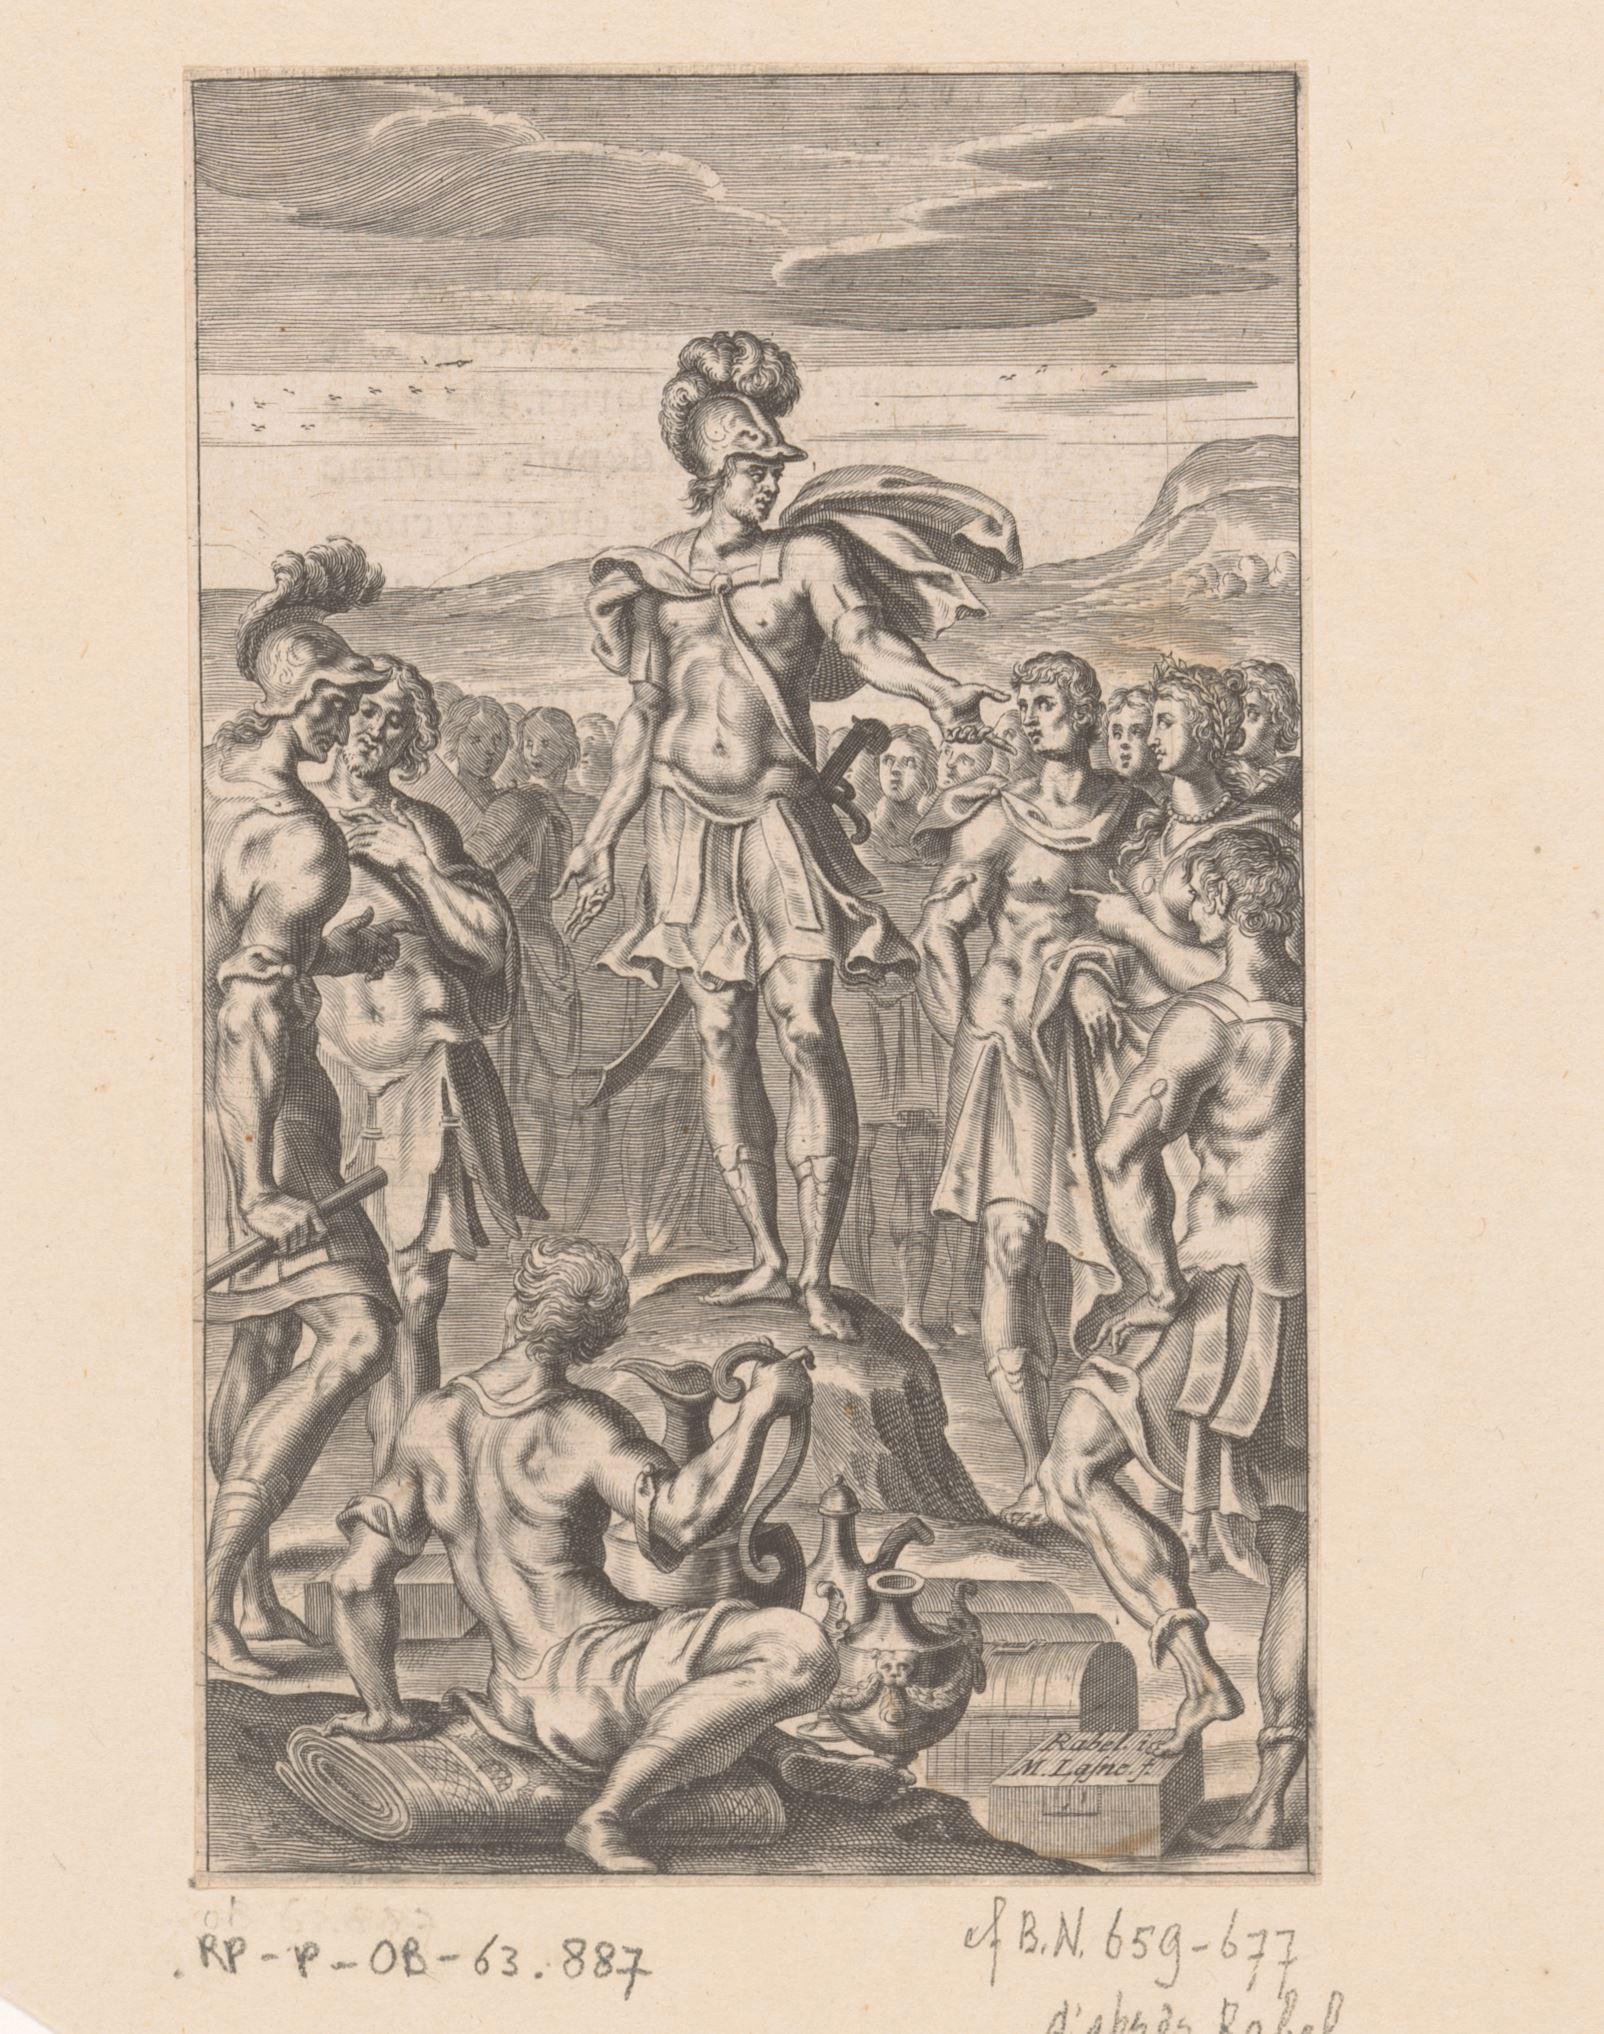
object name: book illustration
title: Harangue van Thiamis en zijn metgezellen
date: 1623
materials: paper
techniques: engraving, letterpress printing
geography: paris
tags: the soldier; the soldier's life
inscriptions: collector's mark: Lugt 240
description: Prent gebruikt voor: Emesenus, Heliodorus. Les amours de Théagène et Chariclée, / Histoire éthiopique de Heliodore. Parijs: Samuel Thiboust, 1623, p. 61.